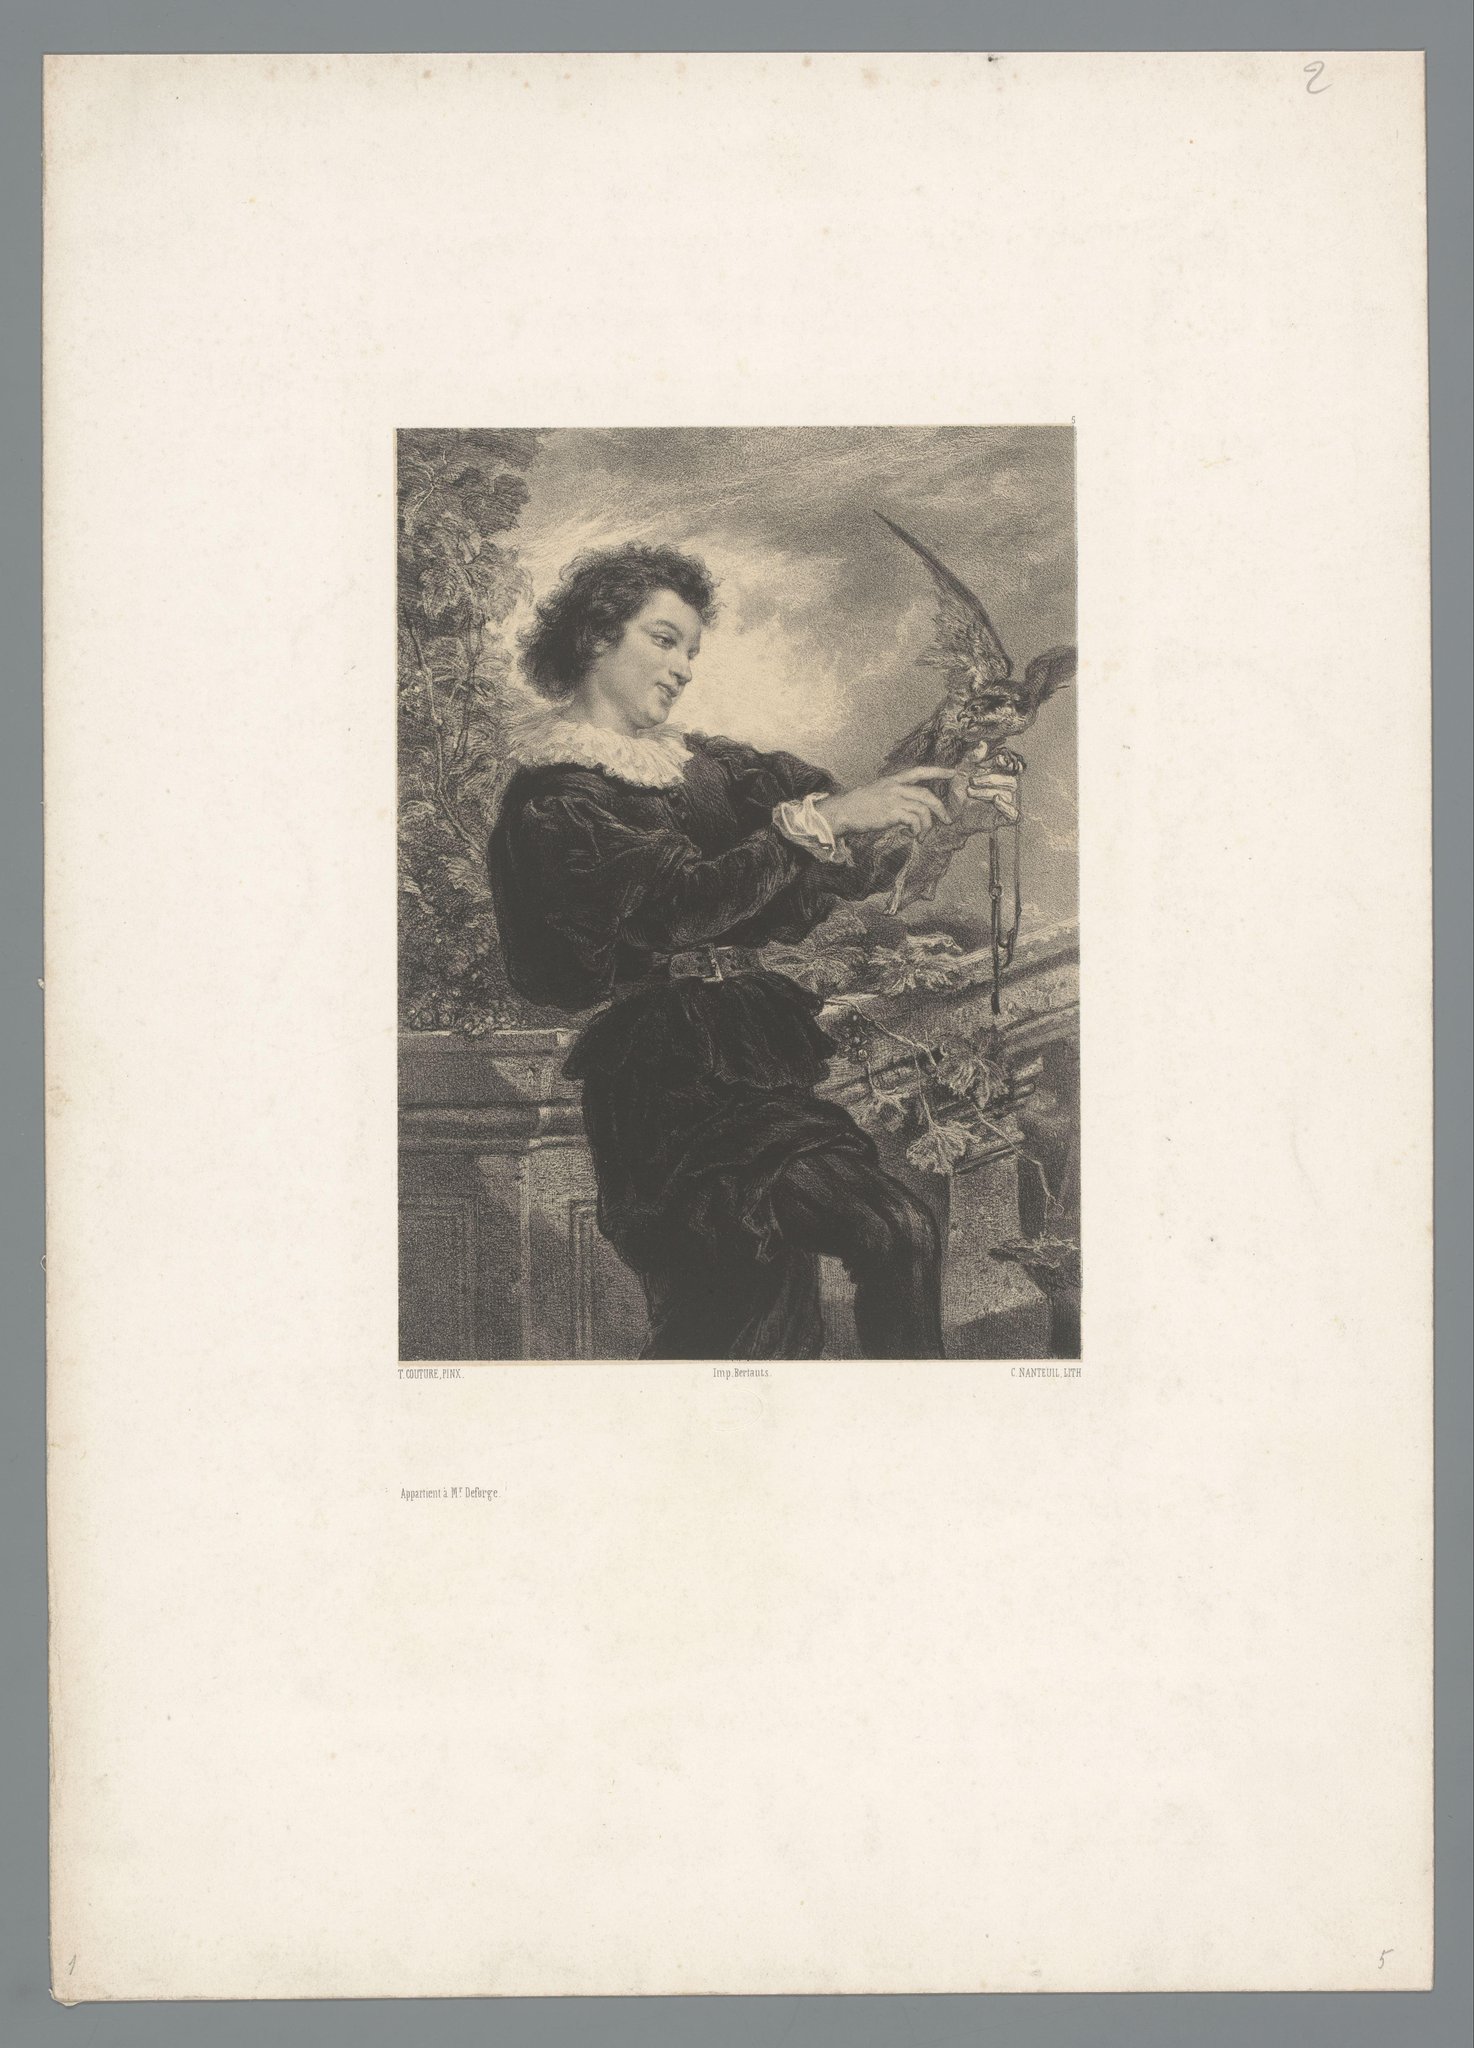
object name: print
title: Oude en hedendaagse kunstenaars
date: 1848-1862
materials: paper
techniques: lithograph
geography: paris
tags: predatory birds: falcon, youth, adolescent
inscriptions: collector's mark: Lugt 2760, check stamp: Lugt 36a, collector's mark: Lugt 2228